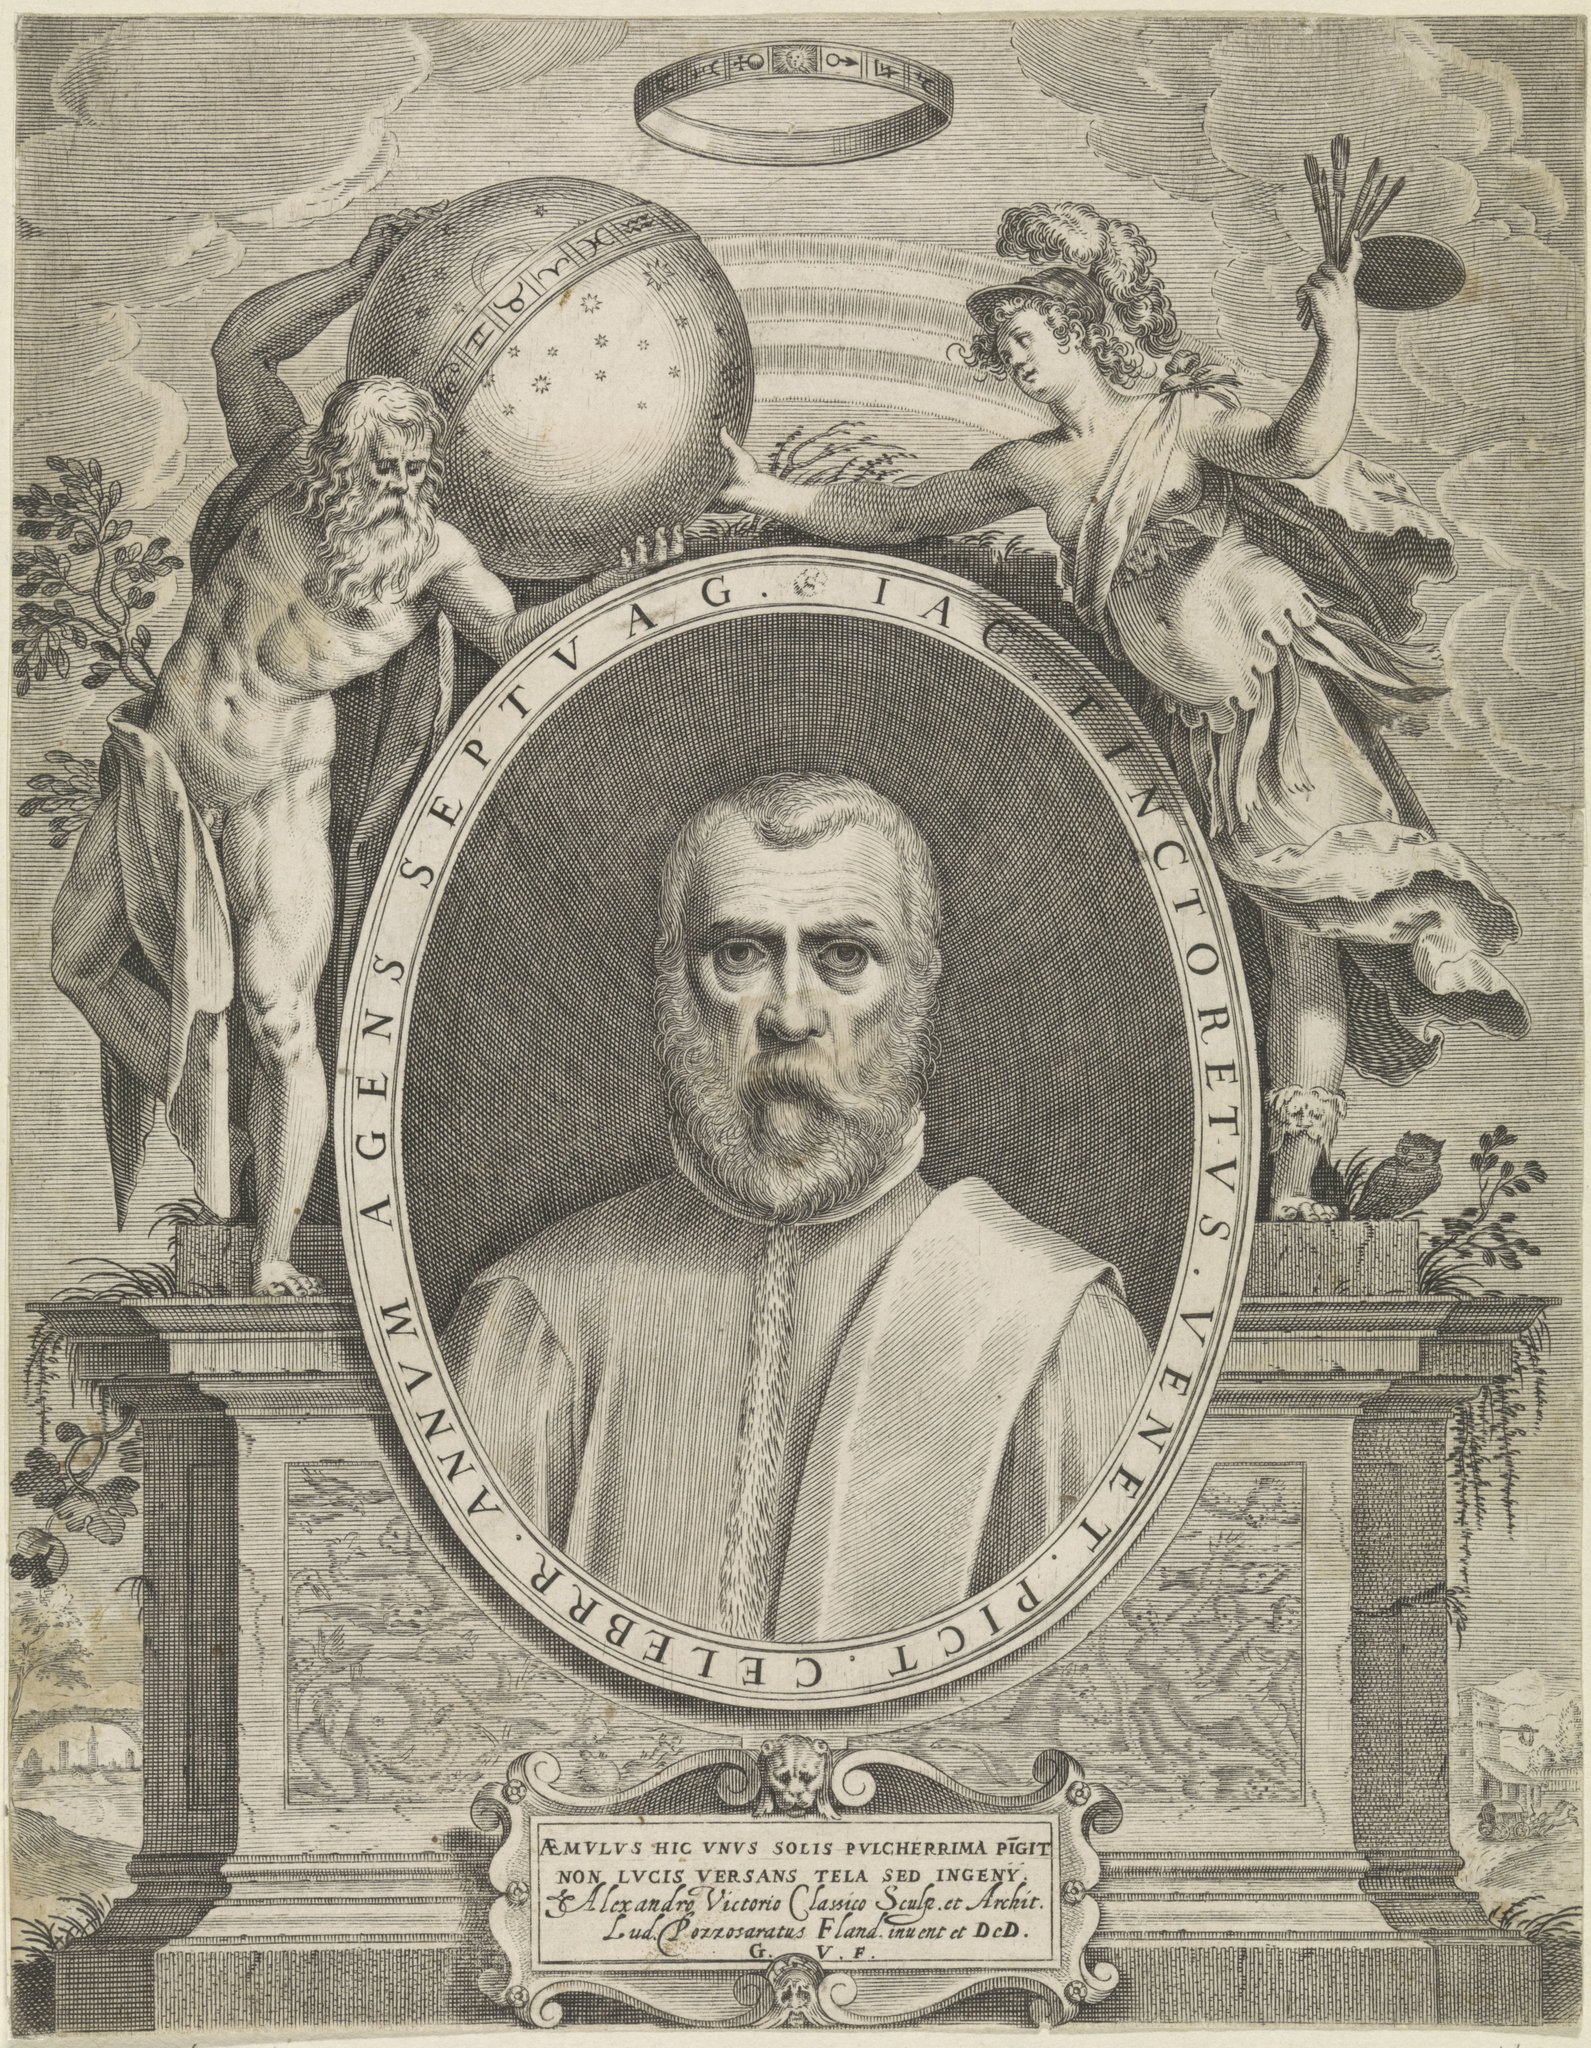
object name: print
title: Portret van Jacopo Tintoretto met Atlas en Minerva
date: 1588-1628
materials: paper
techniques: engraving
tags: venice, painter, draughtsman, jacopo tintoretto, atlas supporting the heavens on his shoulders, specific aspects, allegorical aspects of minerva; minerva as patroness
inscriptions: collector's mark: Lugt 240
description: Naar een portret van Tintoretto in het Louvre, Parijs (inv.nr. 572).